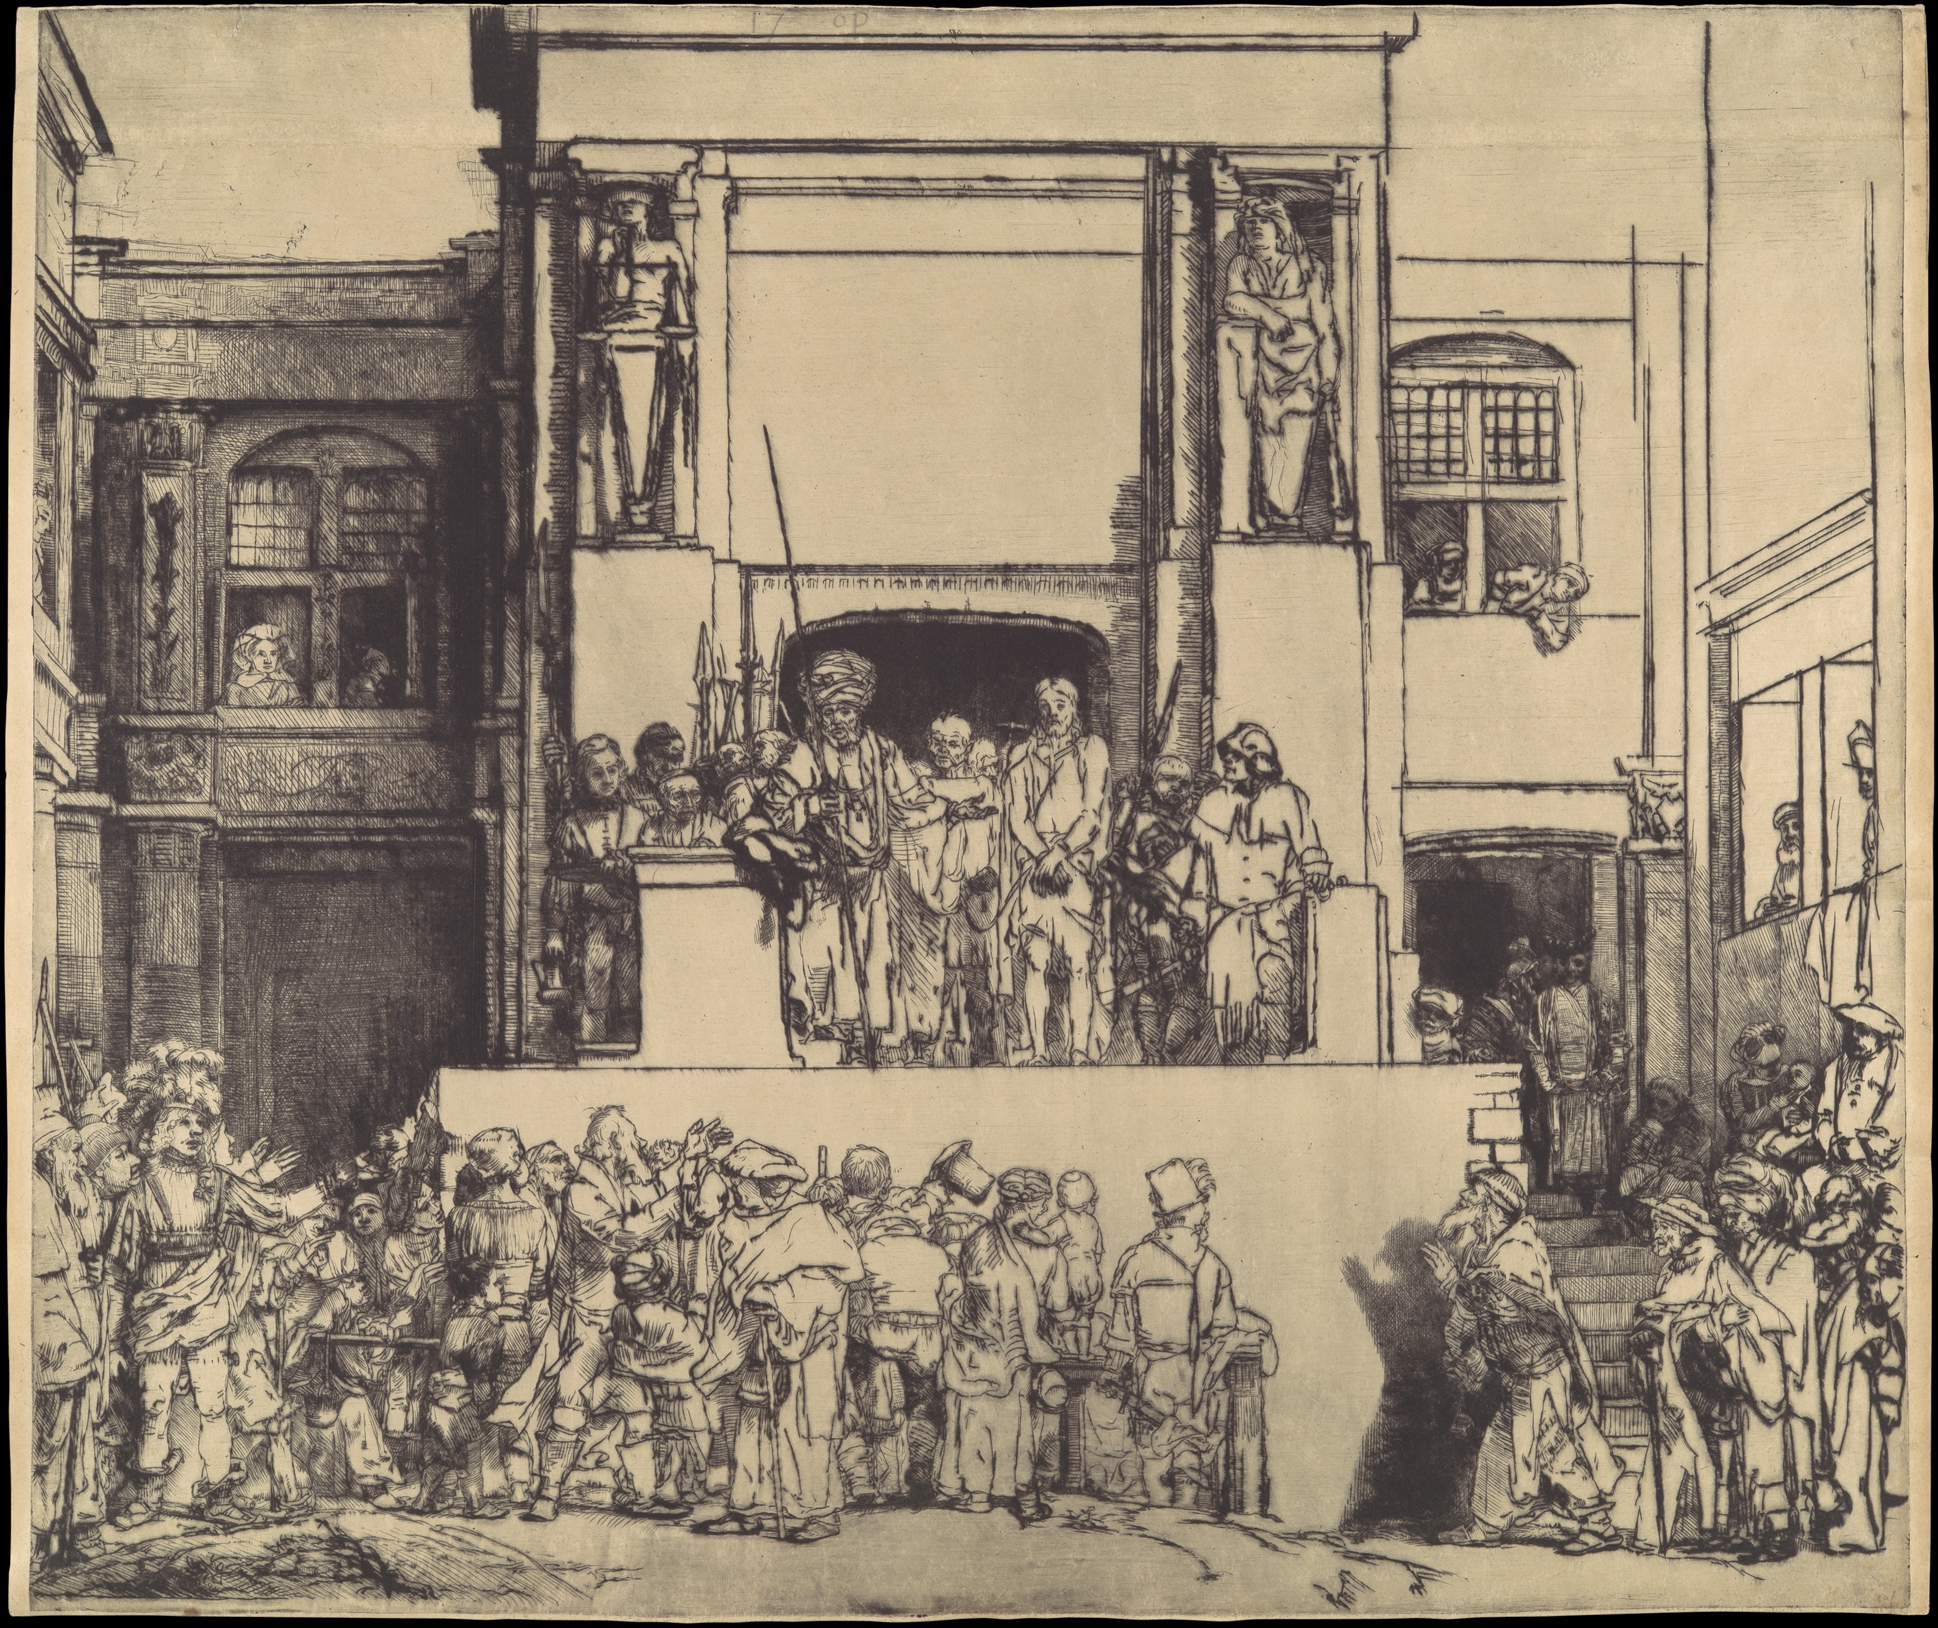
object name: print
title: Christ Presented to the People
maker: rembrandt van rijn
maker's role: artist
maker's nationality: dutch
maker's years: 1606-1669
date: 1655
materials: paper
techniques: drypoint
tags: christ,crowd